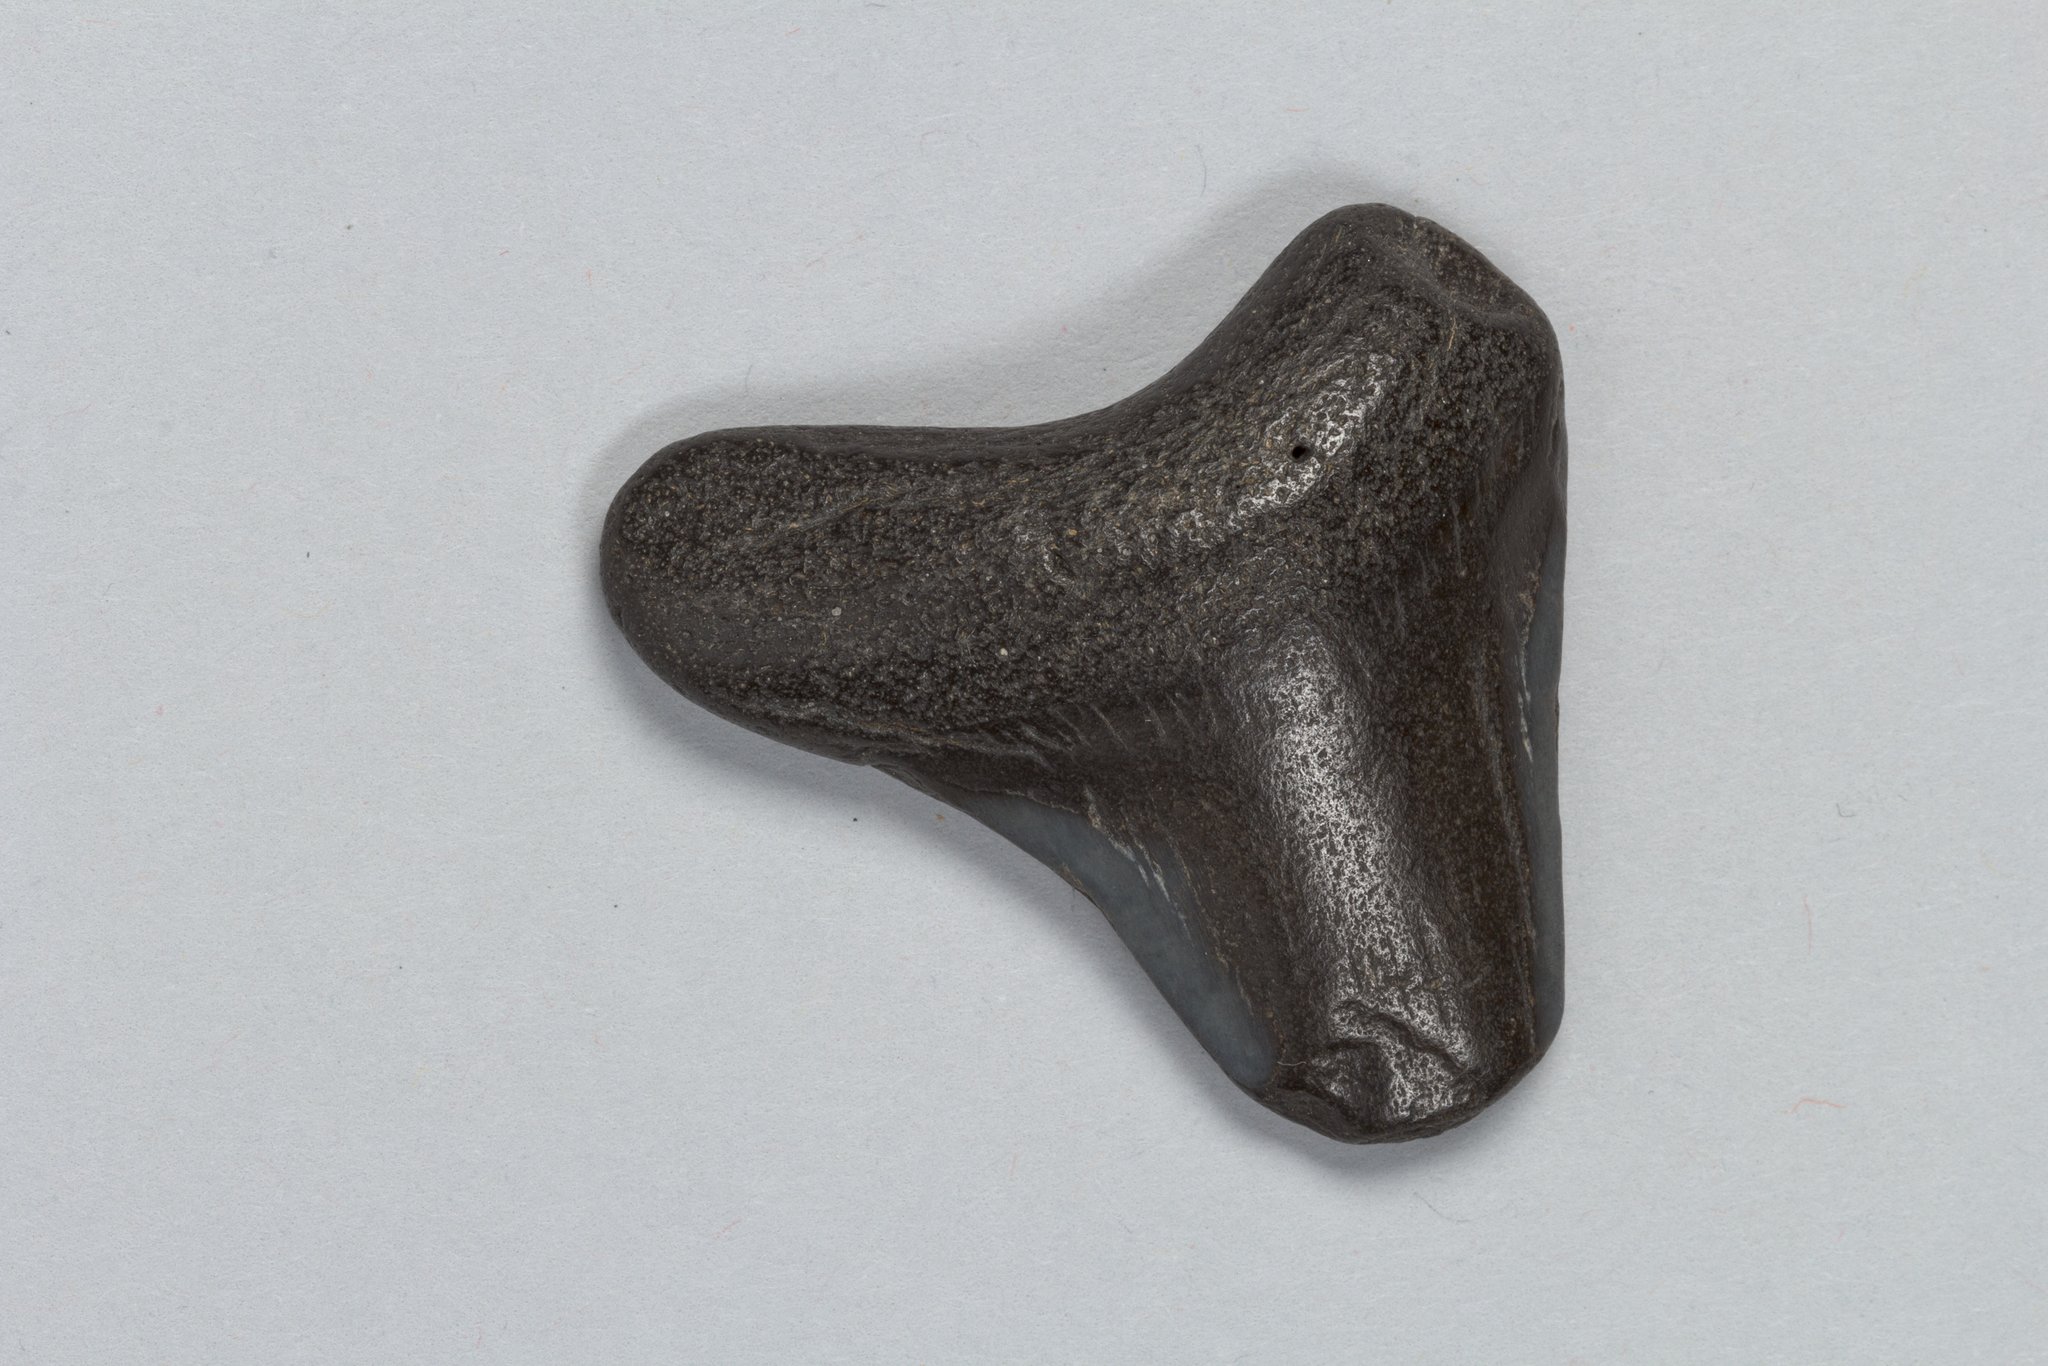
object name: oracle bone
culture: chinese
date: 1801-1900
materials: bone